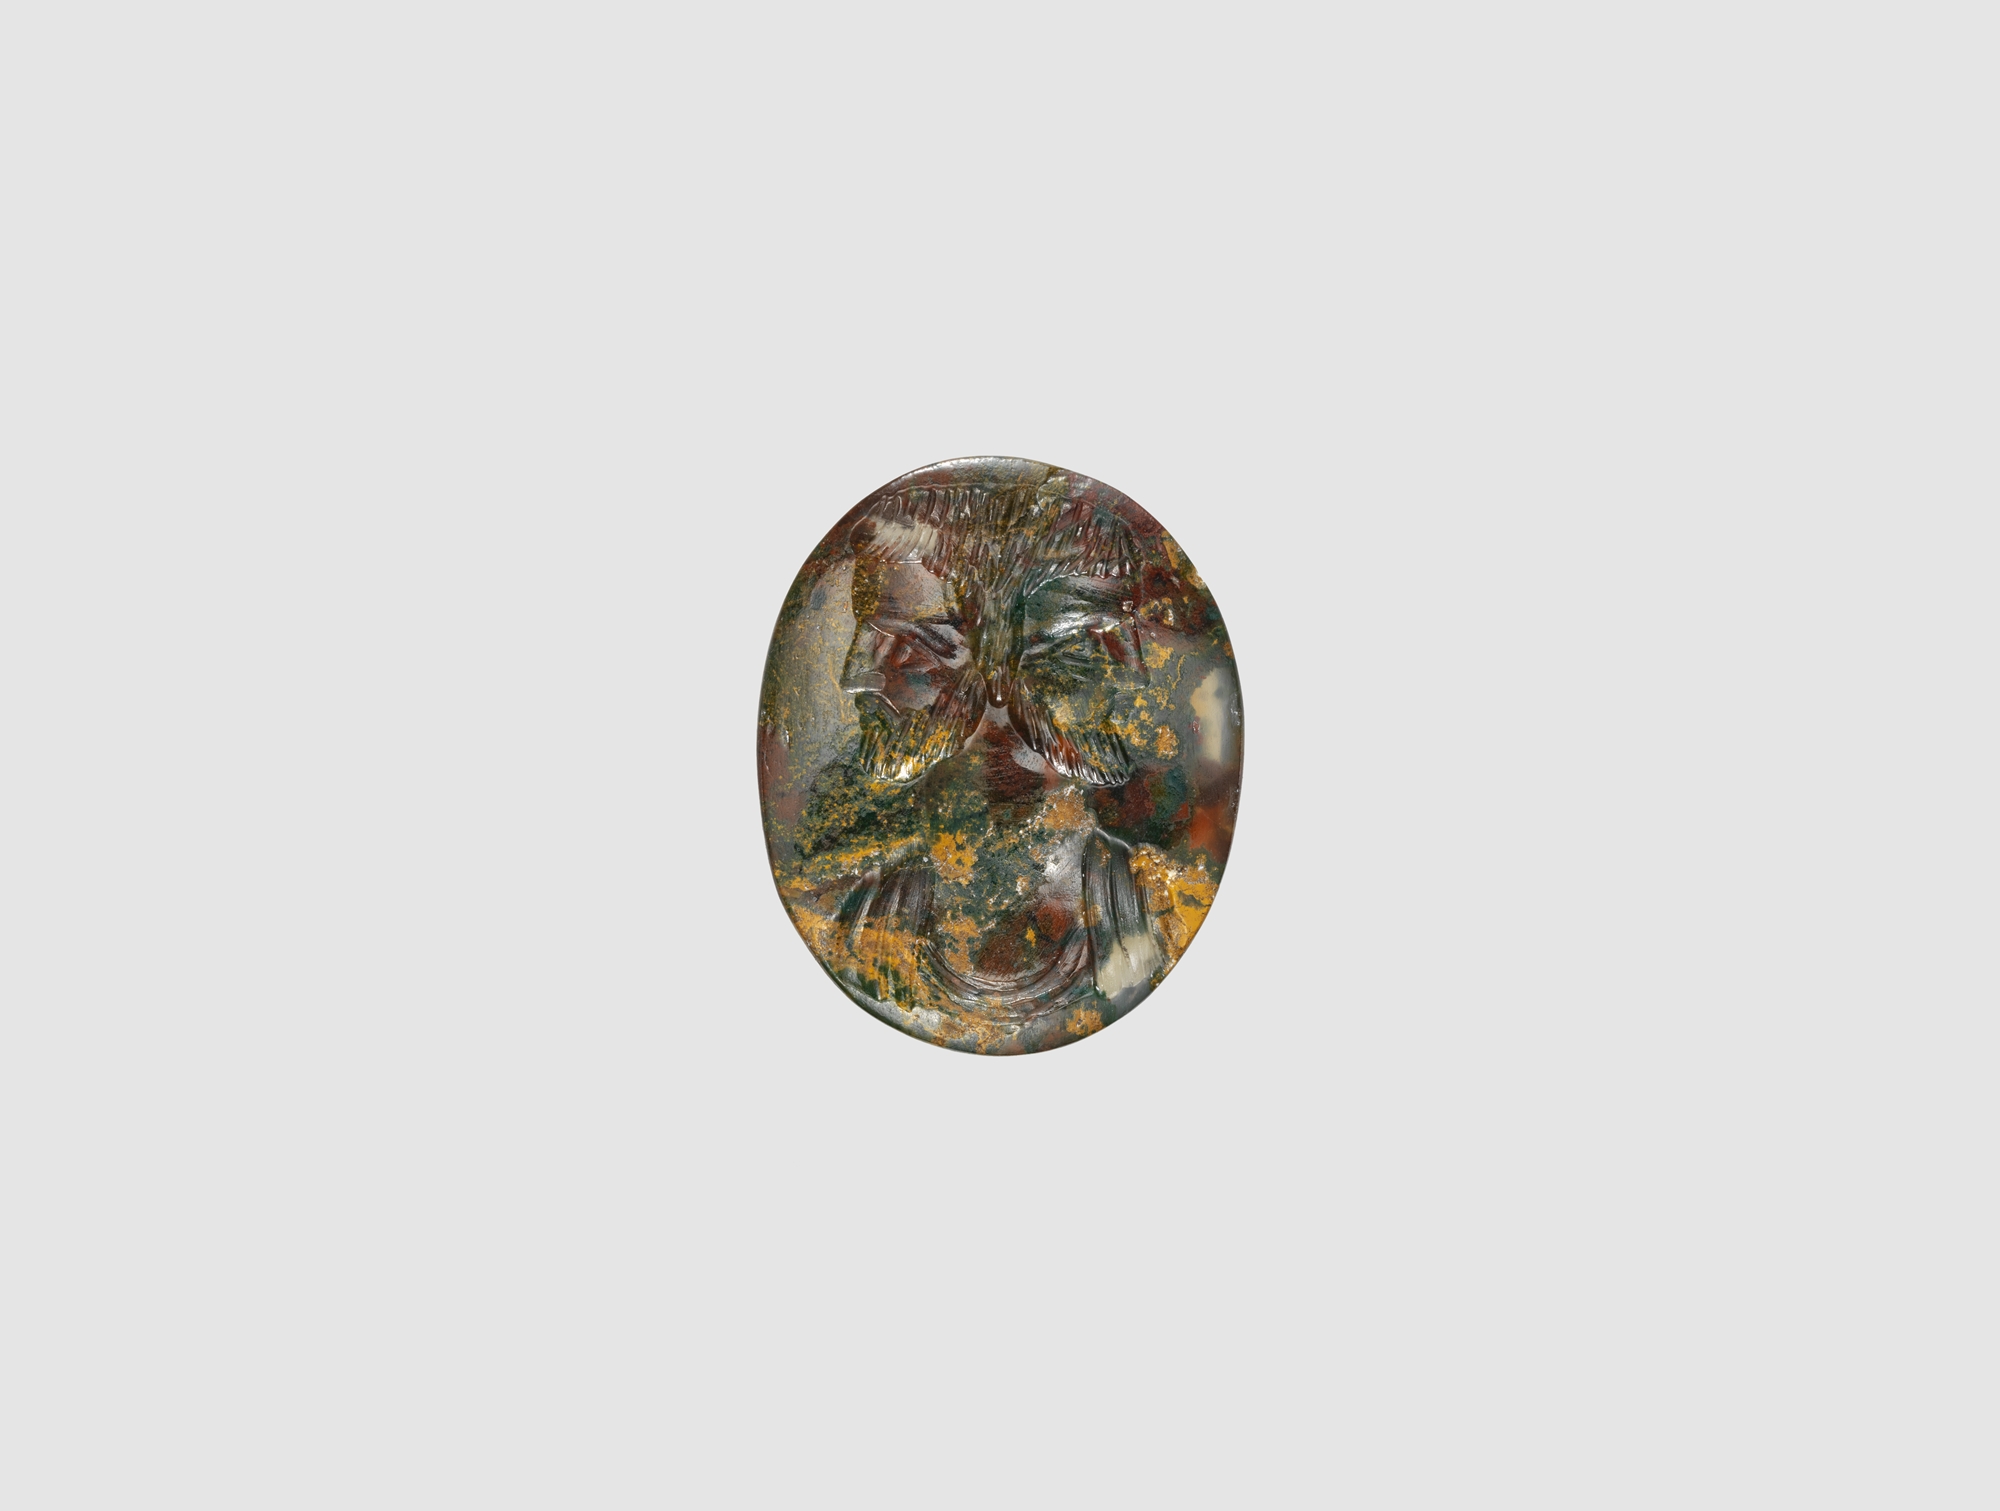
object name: intaglio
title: Jasper ring stone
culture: roman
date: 100 BCE-300 CE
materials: jasper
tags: heads,men